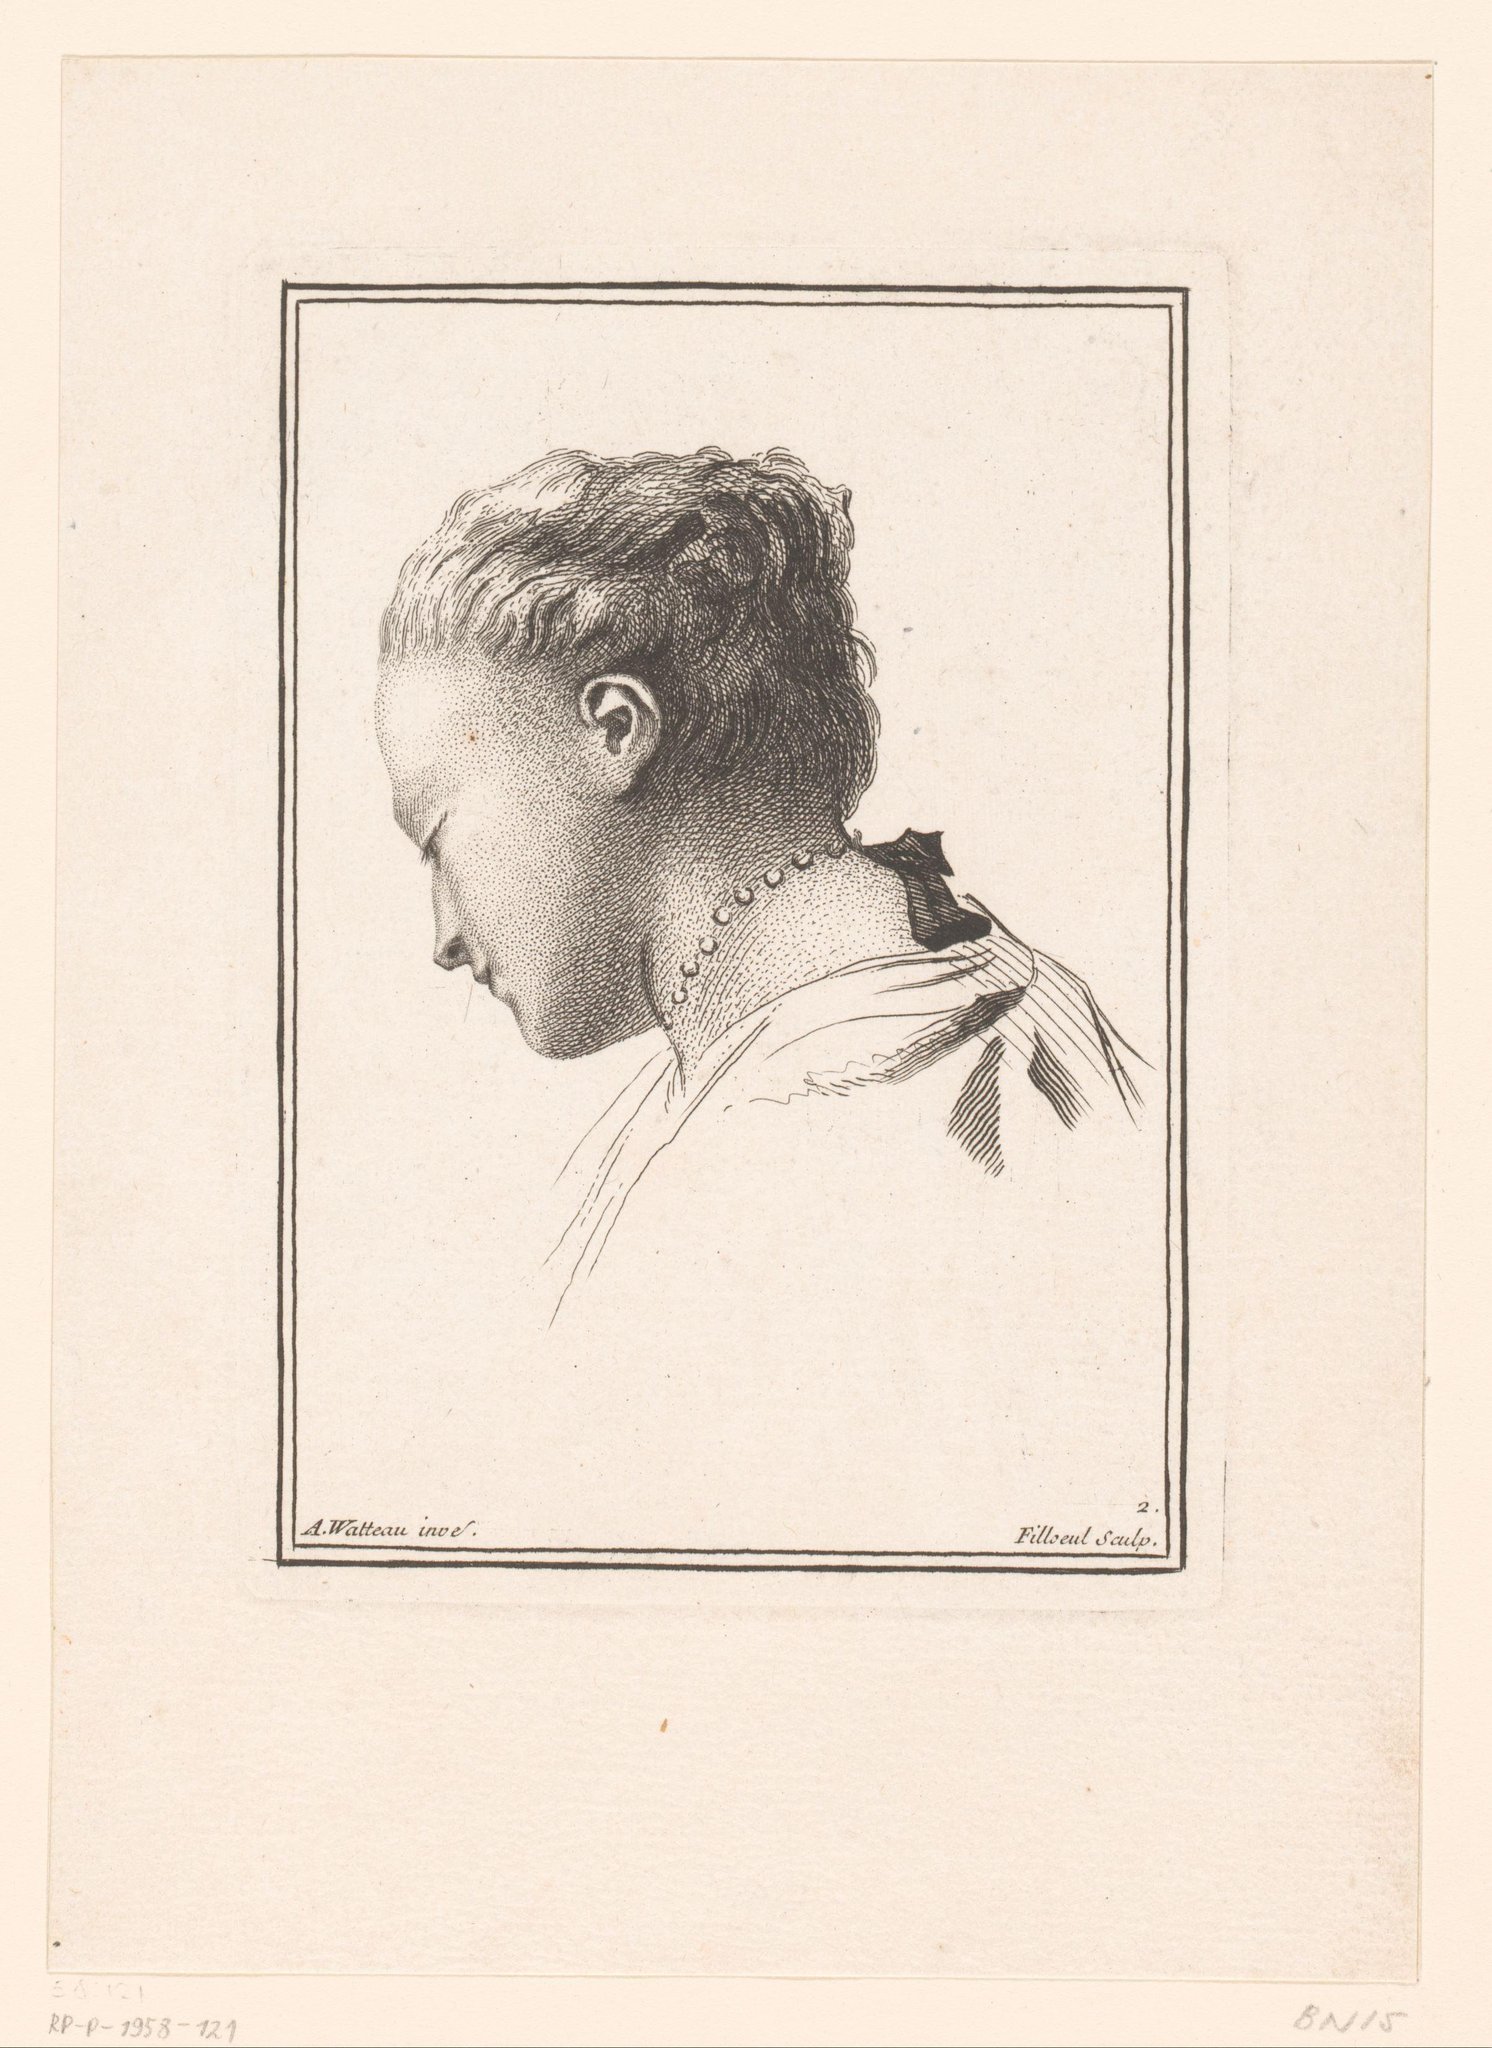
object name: print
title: Portret van een onbekende vrouw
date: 1734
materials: paper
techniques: engraving, etching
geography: france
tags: adult woman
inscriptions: collector's mark: Lugt 533b